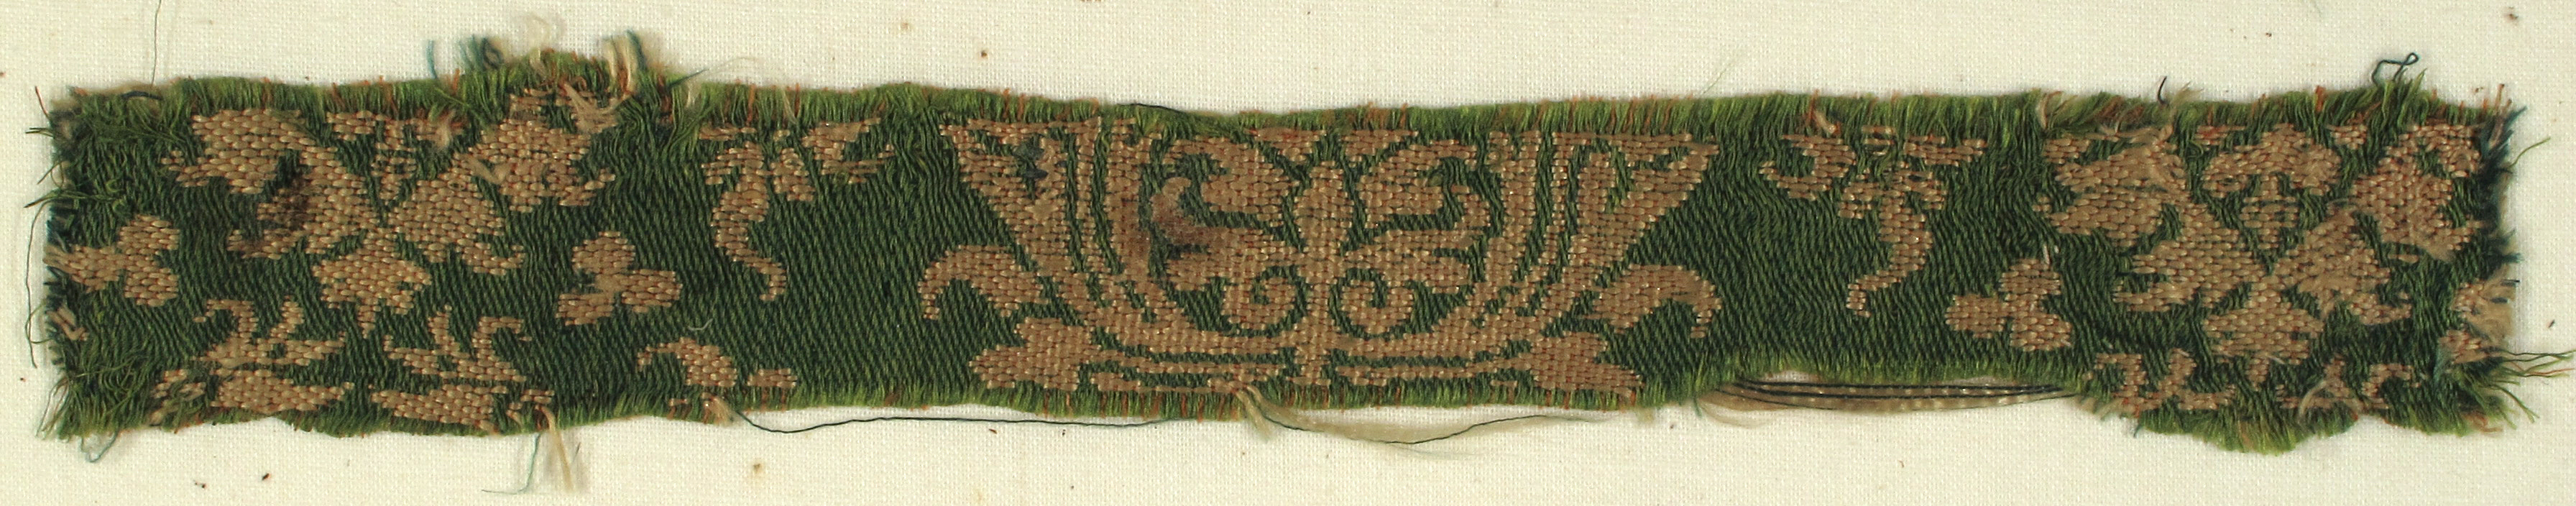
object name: textile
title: Textile with Figures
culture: italian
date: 1301-1400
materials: silk